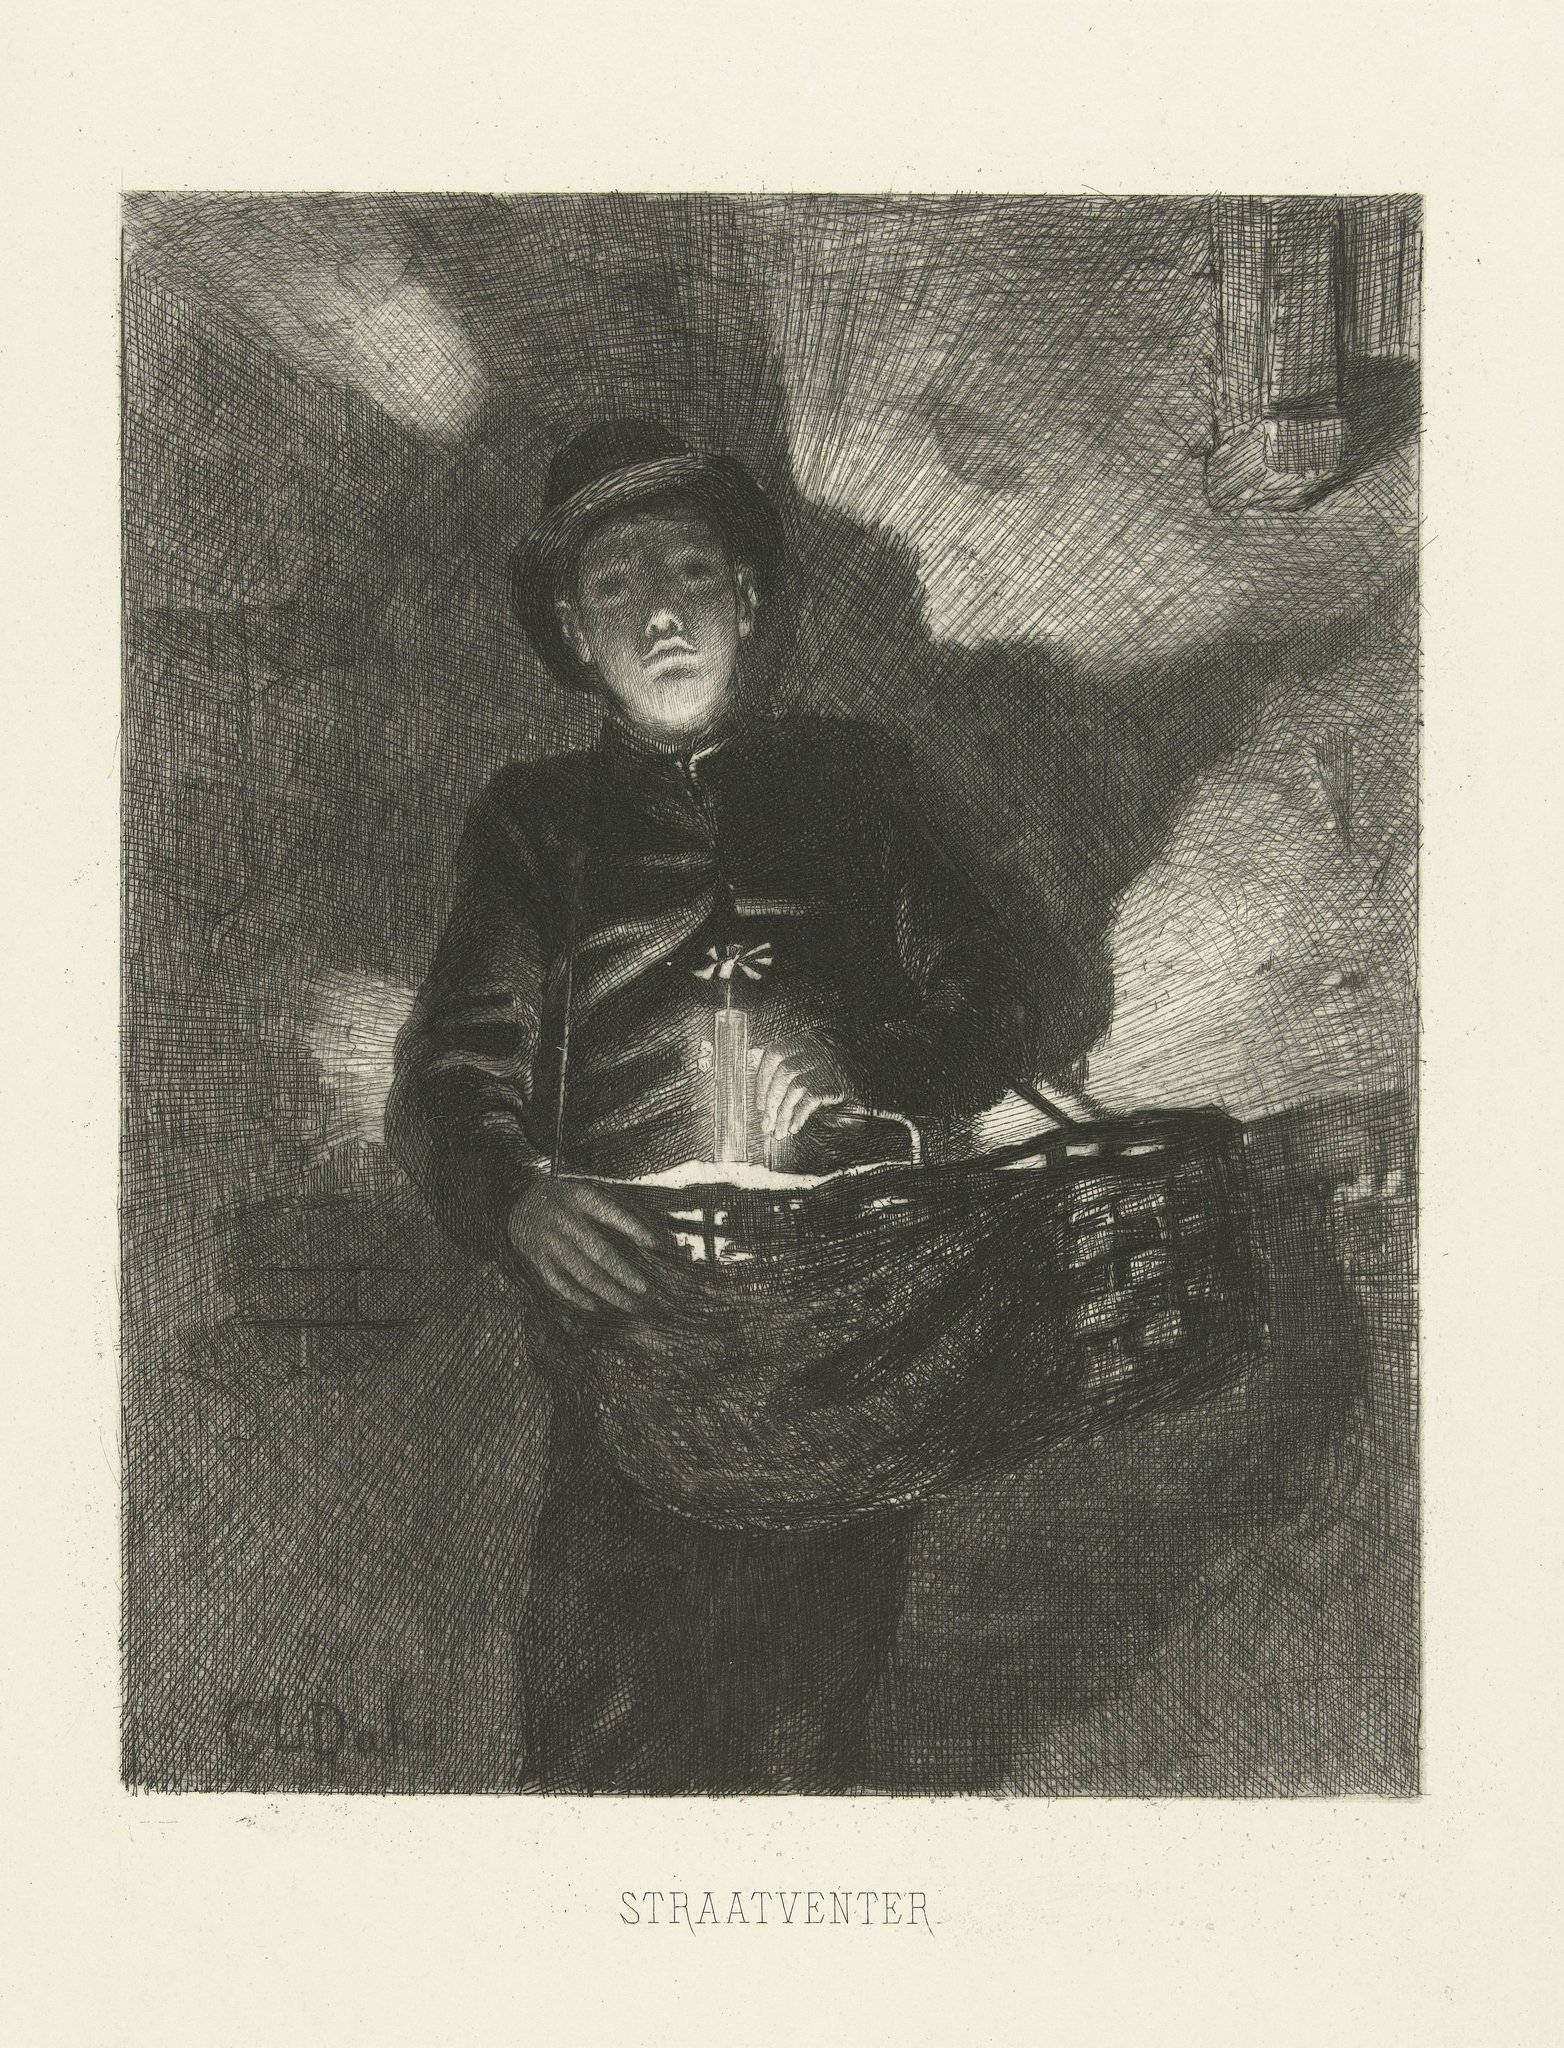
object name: print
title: Jongen als straatventer met mand met koopwaren bij avond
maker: carel lodewijk dake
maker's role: draughtsman, painter, print maker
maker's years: 1857-1918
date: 1867-1886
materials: paper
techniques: drypoint, etching, intaglio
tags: evening, street-trader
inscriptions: collector's mark: Lugt 2228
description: Jongen als straatventer staat met een mand met koopwaren hangend aan zijn schouder voor een muur bij avond. In de mand brand een kaars welke het gelaat van de jongen van onderen belicht en waardoor er een grillige schaduw valt op de muur achter hem.